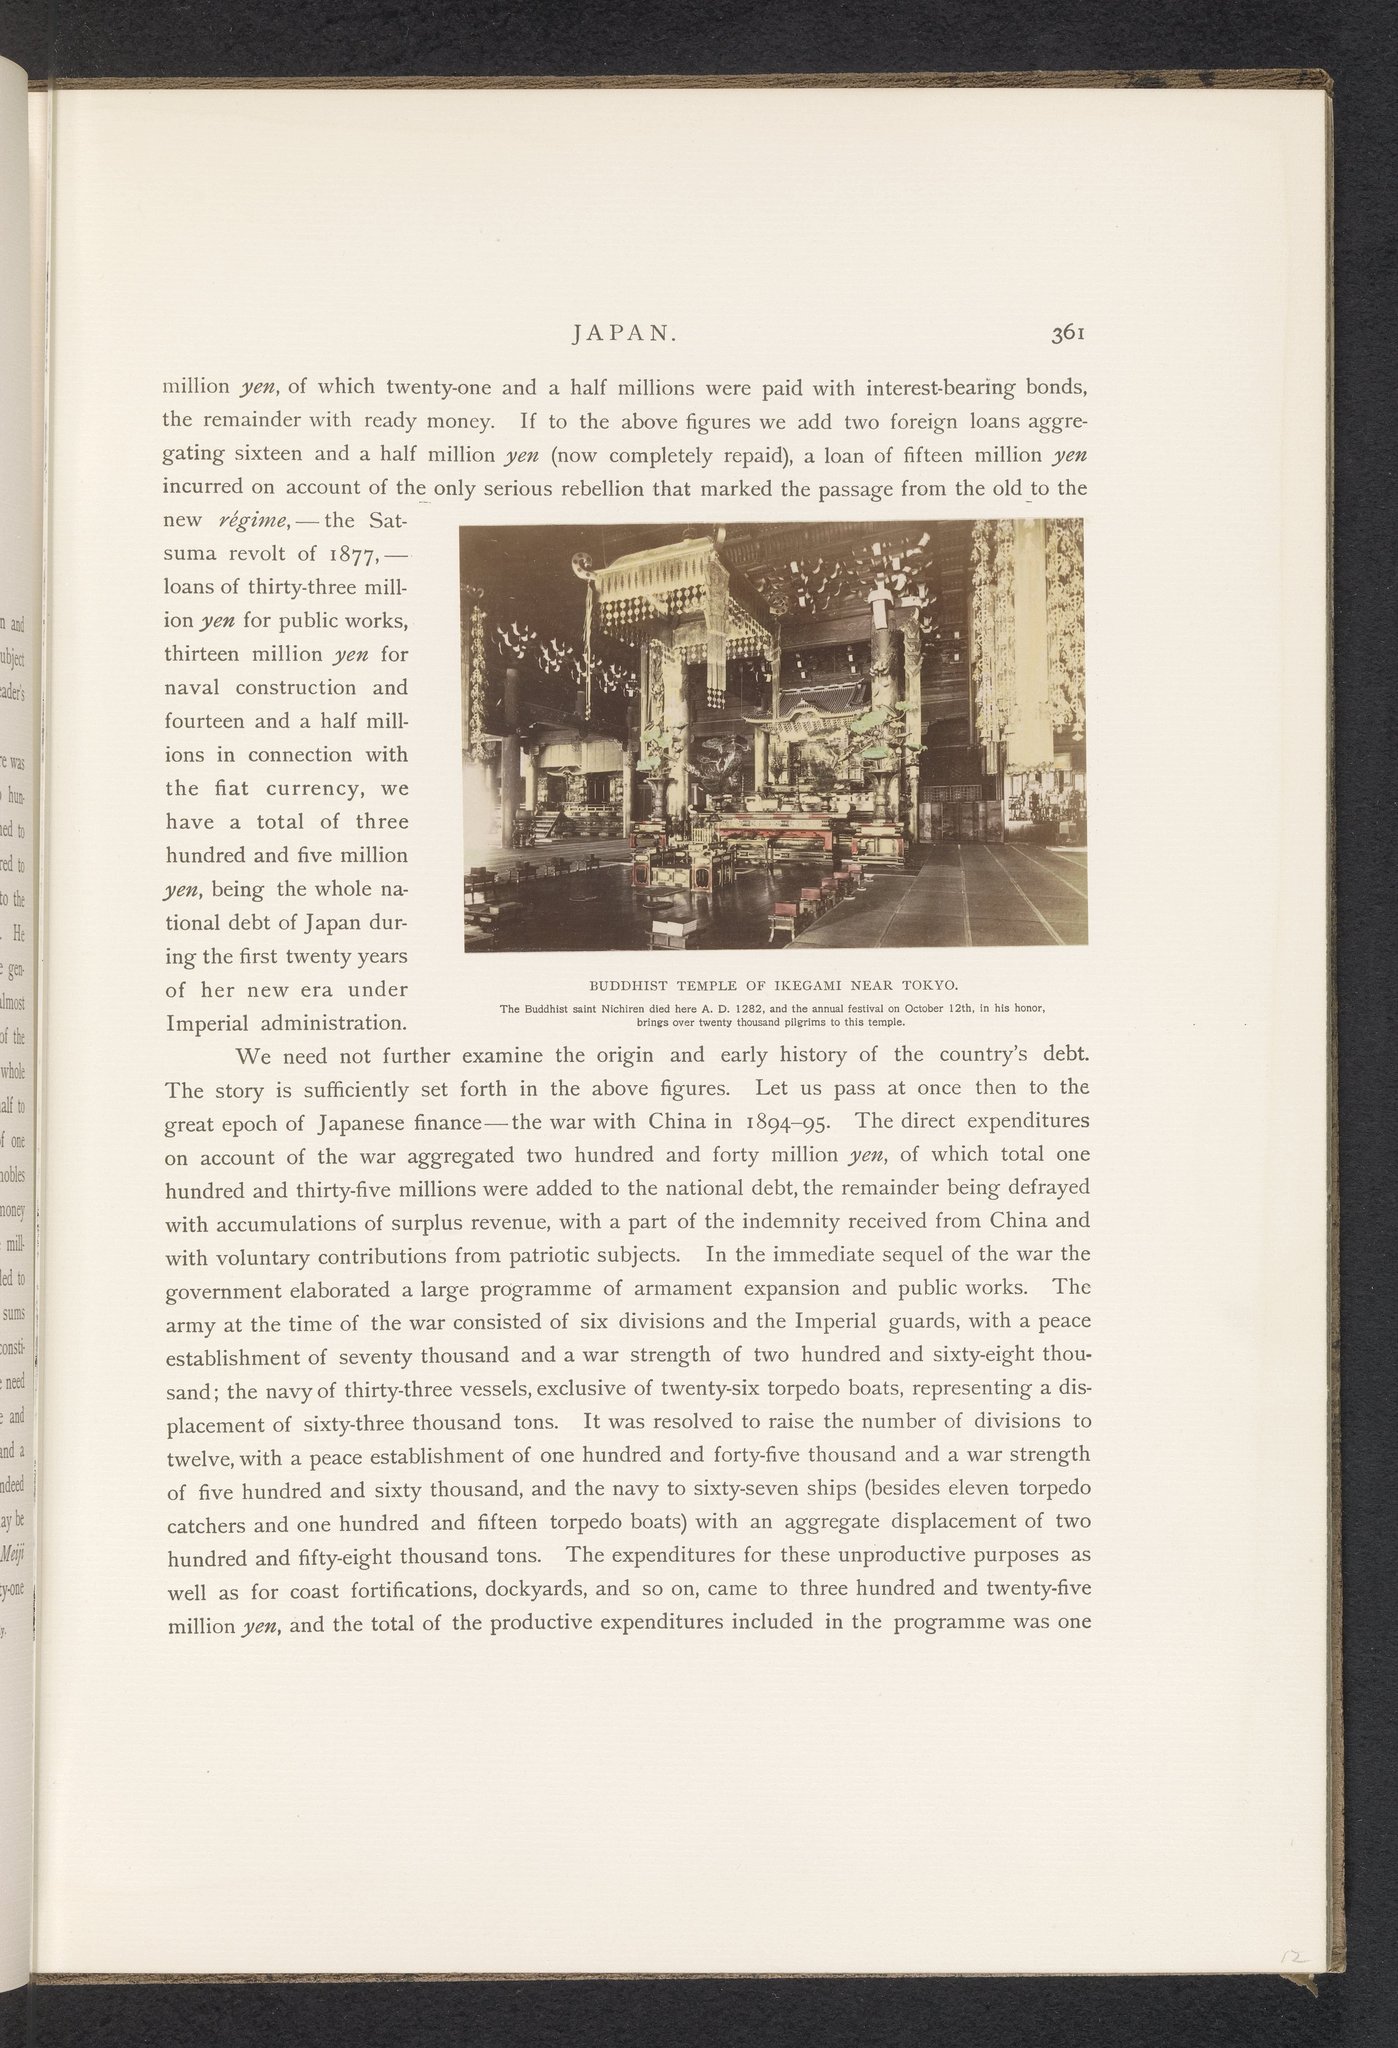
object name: page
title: Buddhist temple of Ikegami near Tokyo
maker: Anonymous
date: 1888-1898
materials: photographic support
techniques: albumen print, hand coloring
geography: japan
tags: temple, shrine ~ hinduism, buddhism, jainism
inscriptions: inscription: ‘The Buddhist saint Nichiren died here (...) over twenty thousand pilgrims to this temple.’